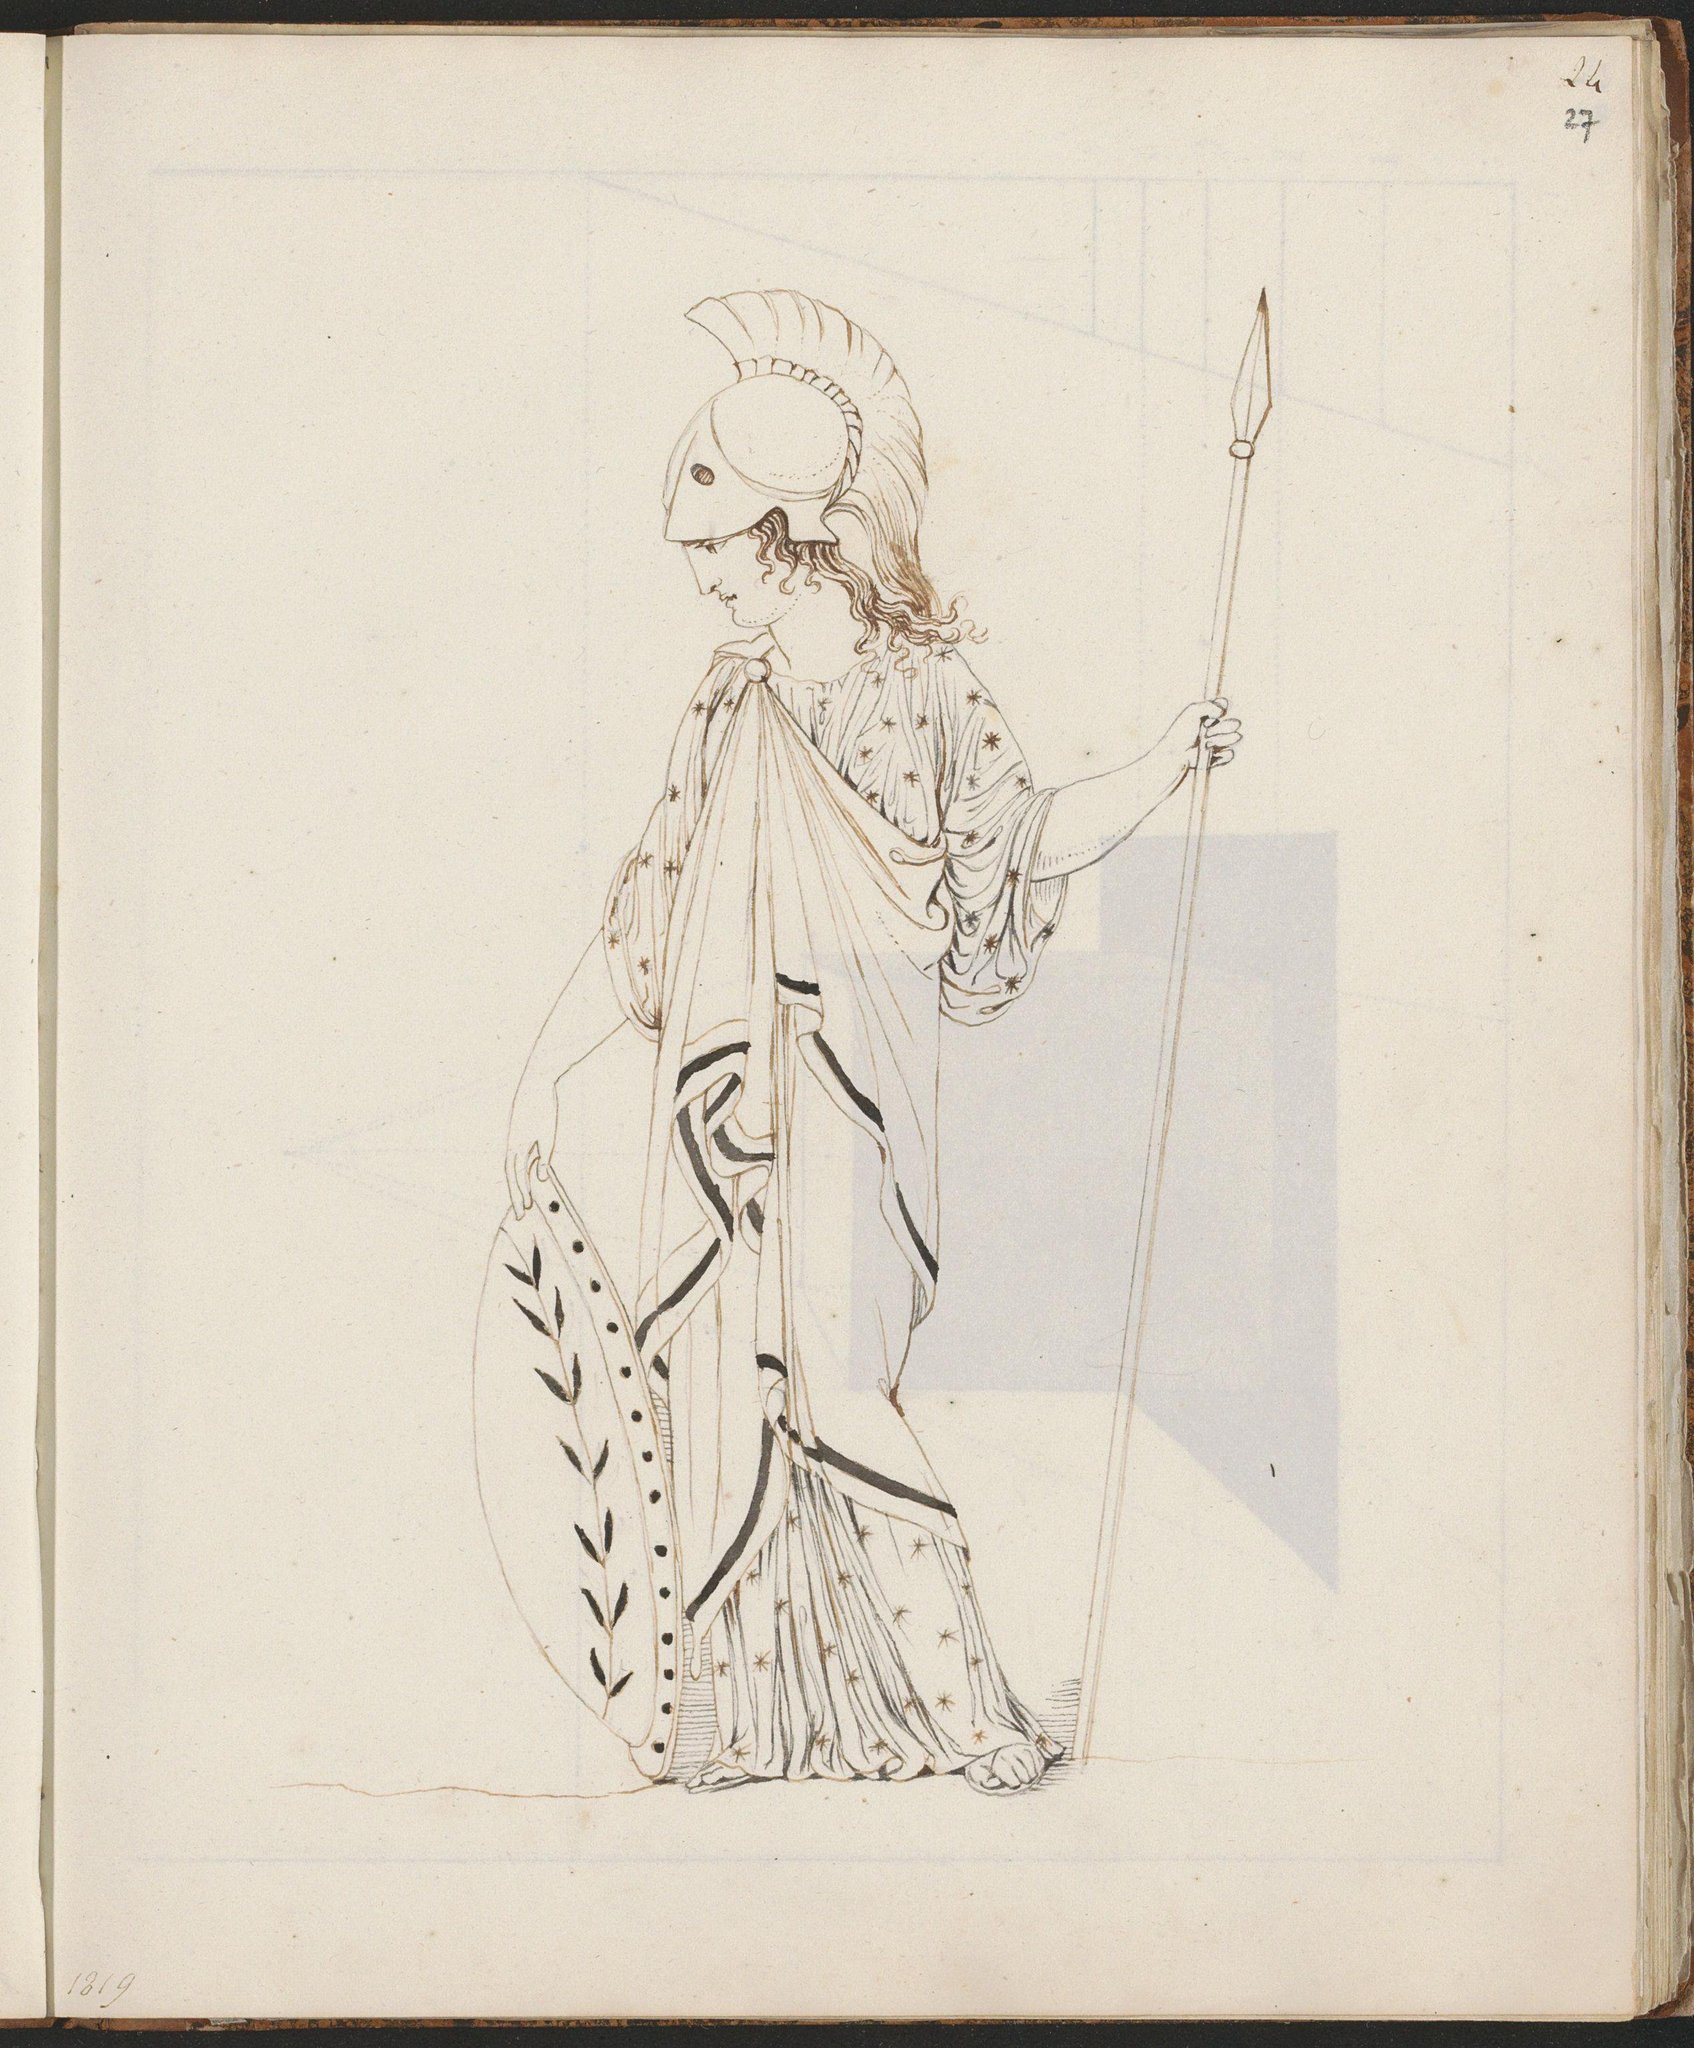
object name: sketchbook leaf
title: Pallas Athena in wapenrusting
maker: jonkvrouw elisabeth kemper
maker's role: draughtsman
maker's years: 1799-1871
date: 1819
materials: ink, paper, pencil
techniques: brush, pen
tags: (story of) minerva (pallas, athena)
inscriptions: date: ‘1819’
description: Pallas Athena staat en draagt een helm, schild en speer. Vermoedelijk getekend naar klassiek voorbeeld. Blad 27 recto uit een schetsboek met 94 bladen.